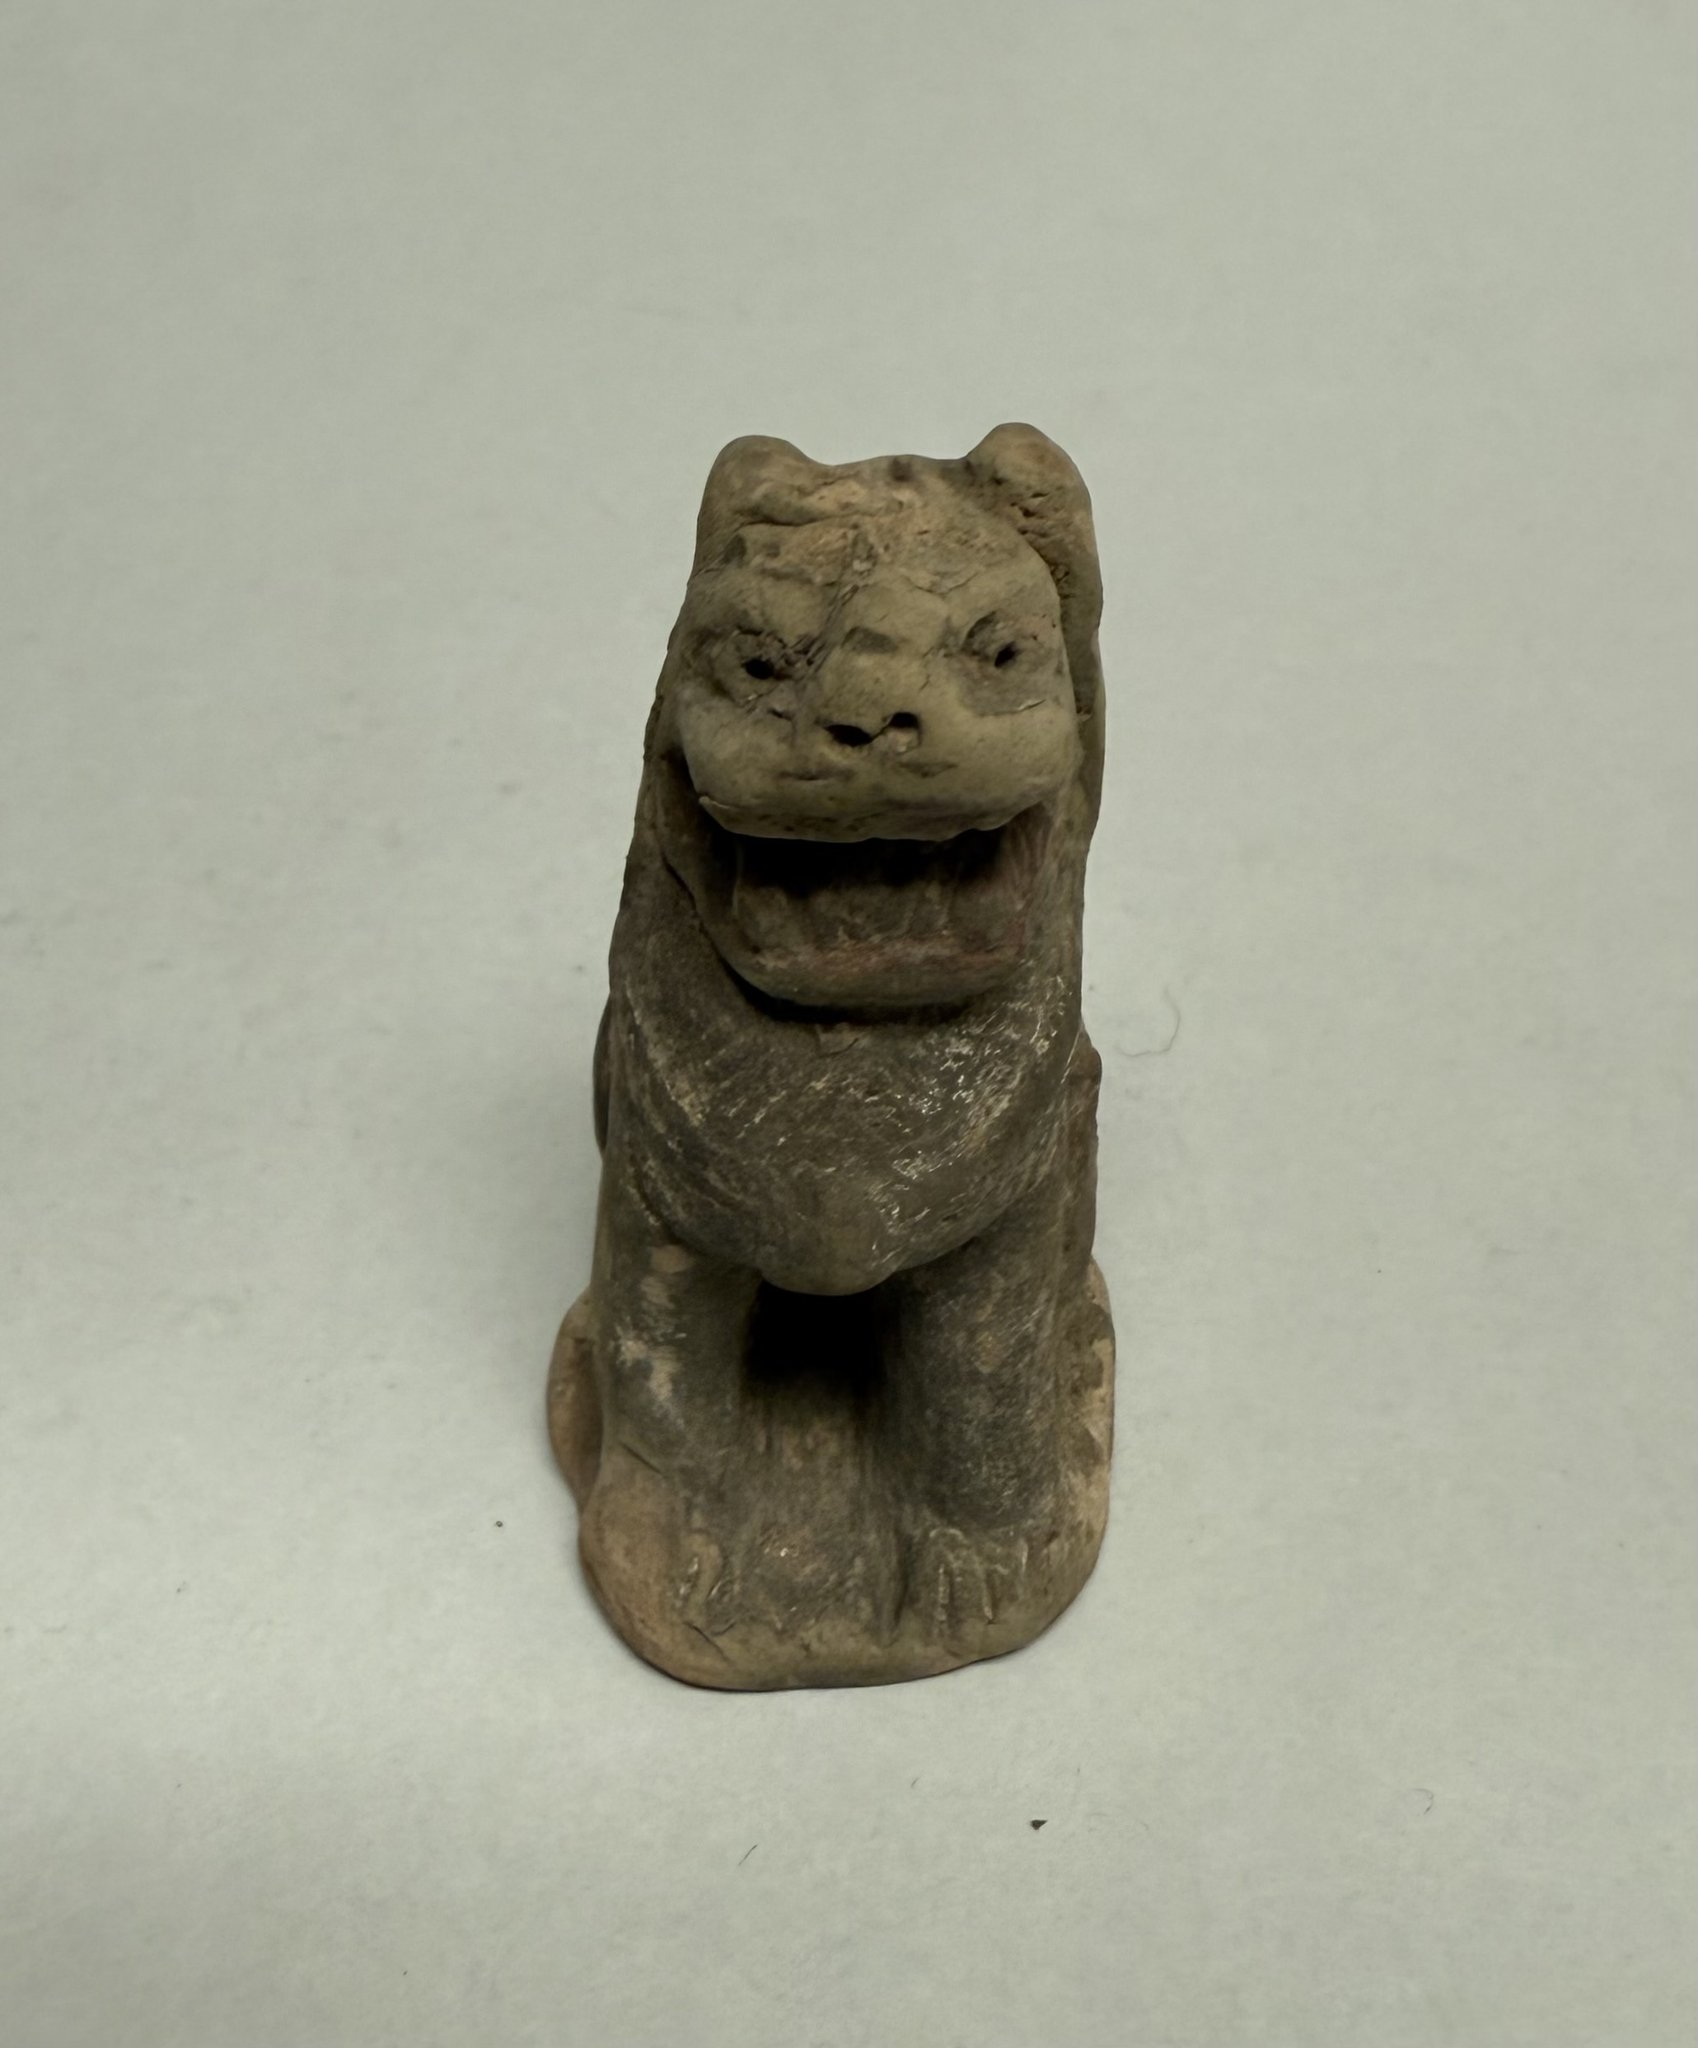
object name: figure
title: Figure of Seated Lion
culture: chinese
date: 960-1279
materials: pottery